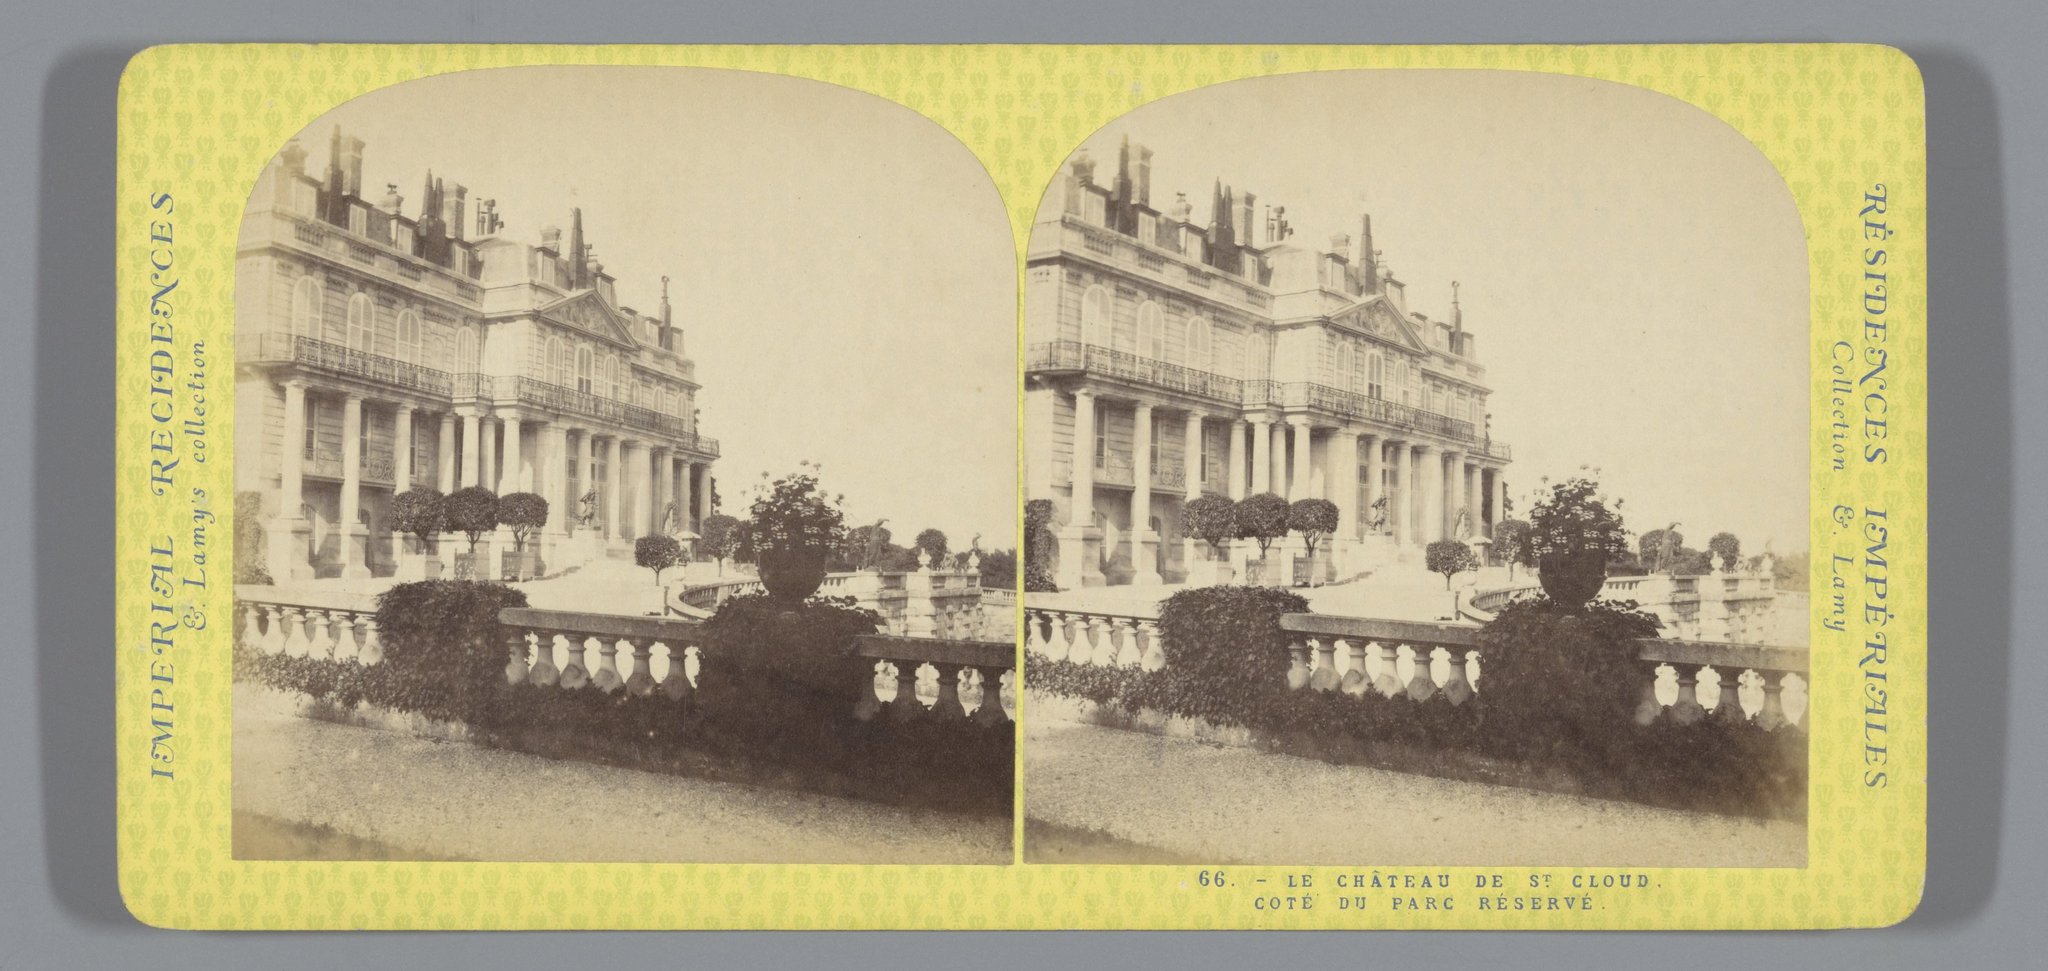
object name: stereograph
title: Le Chateau de St. Cloud, coté du parc reservé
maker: ernest eléonor pierre lamy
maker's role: publisher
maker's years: 1828-1900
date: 1860-1870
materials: cardboard, photographic support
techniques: albumen print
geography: château de saint-cloud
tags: castle, façade (of house or building)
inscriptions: number: ‘66.’, inscription: ‘E. Lamy's collection’